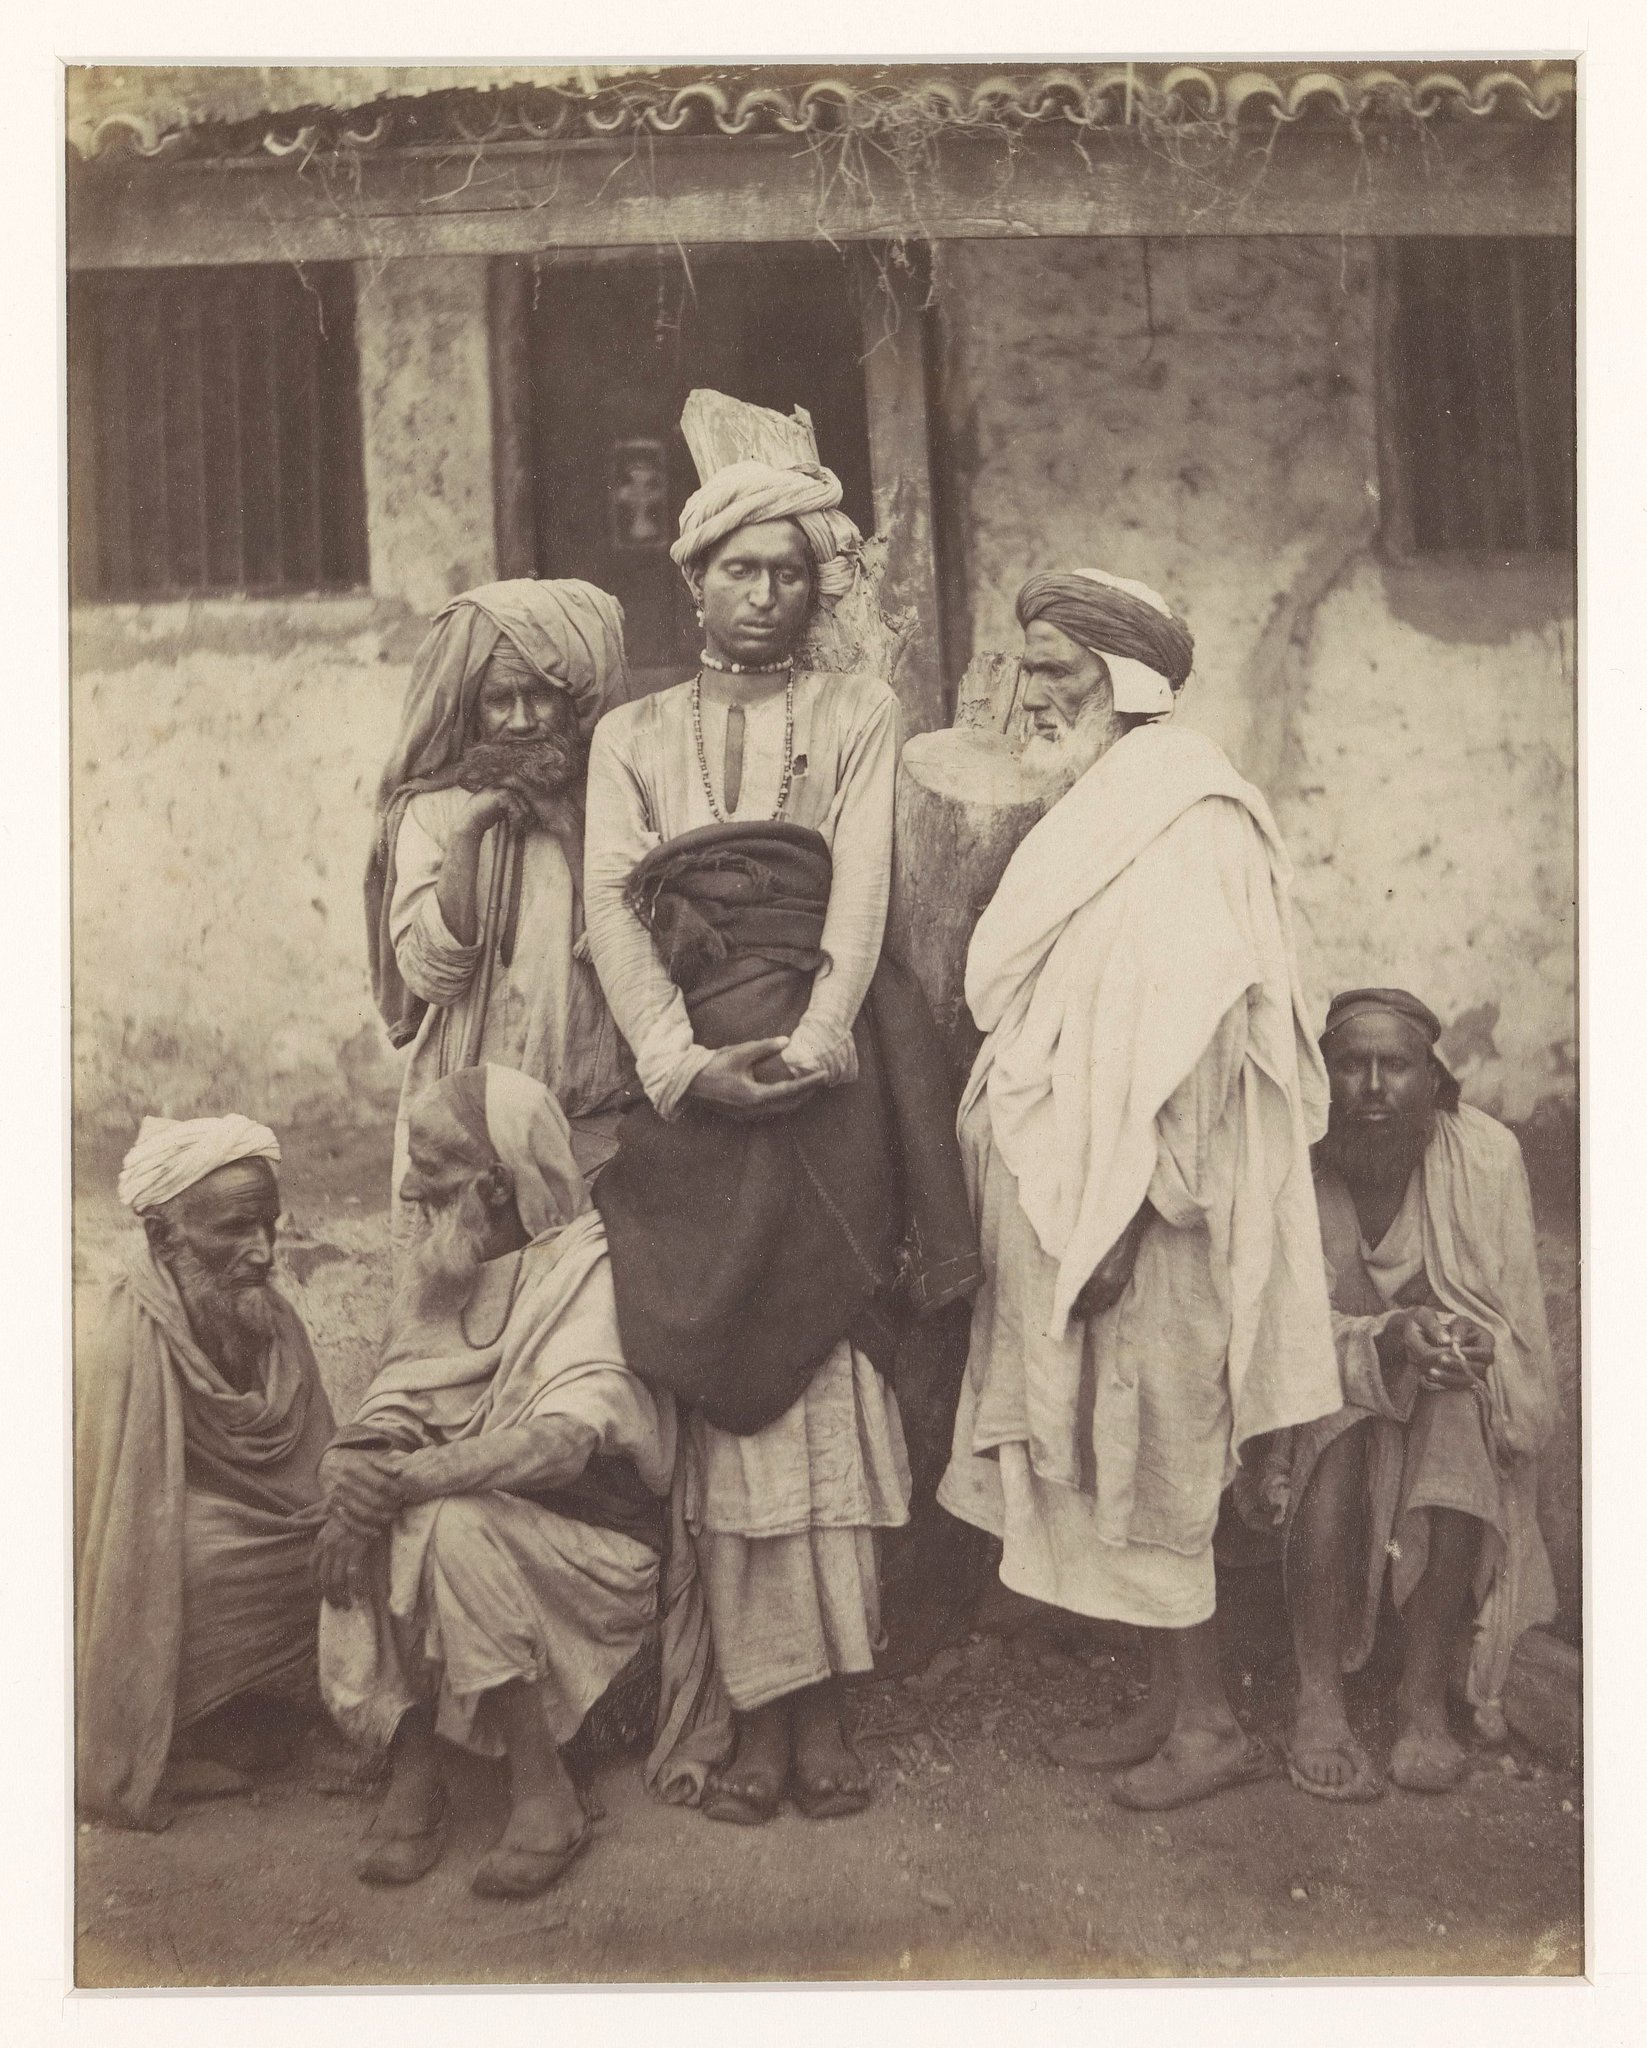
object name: photograph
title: Group portrait van six unknown men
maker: Anonymous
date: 1860-1880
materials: paper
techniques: albumen print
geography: british india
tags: adult man, anonymous historical persons portrayed in a group, in a group-portrait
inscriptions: number: ‘17’